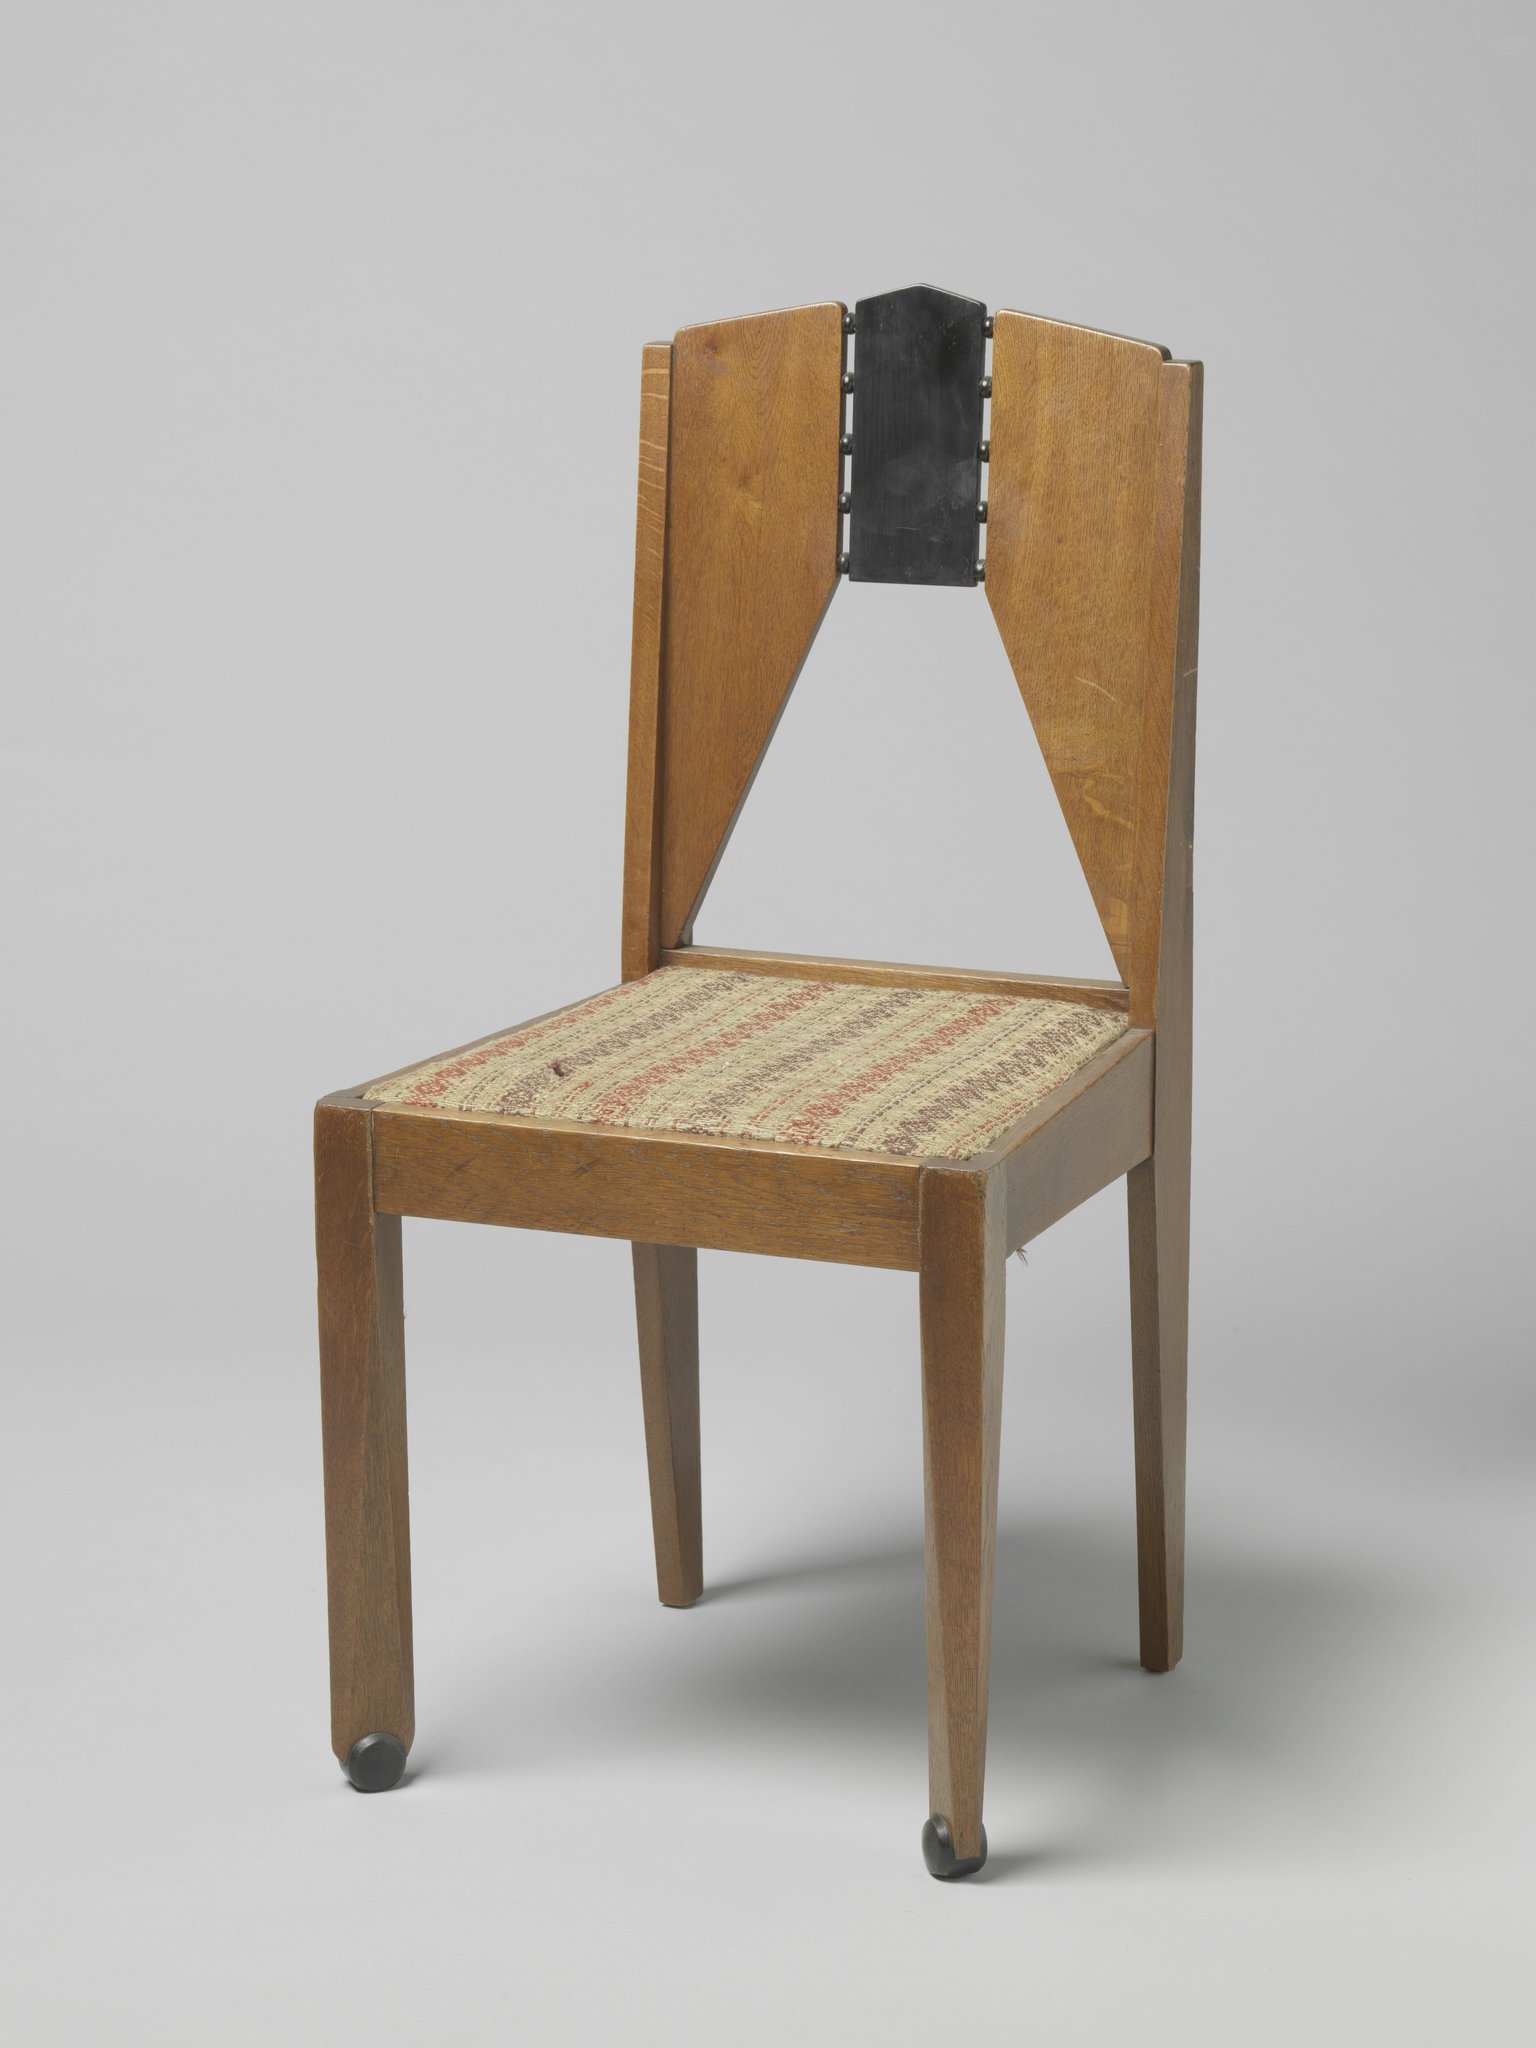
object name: furniture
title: Stoel met trapeziumvormige open ruimte in de rugleuning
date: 1920-1930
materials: wood, textile, wool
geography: amsterdam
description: Stoel van eikenhout rustend op vier poten. De voorpoten zijn afgeschuind en rusten op zwartgebeitste schijven met bolle zijkanten. De achterpoten lopen door in de rugstijlen en verbreden vanaf onder waarna zij ter hoogte van het midden naar boven versmallen. De rugleuning is samengesteld uit drie panelen. Deze zijn zodanig gevormd dat aan de bovenzijde een driehoekige vorm en aan de onderzijde een open trapeziumvorm is ontstaan. De twee buitenste panelen worden door middel van vijf kralen aan iedere zijde verbonden aan het zwart gebeitste middenpaneel. De zitting is bekleed met gestreepte stof in beige, rood en paars.